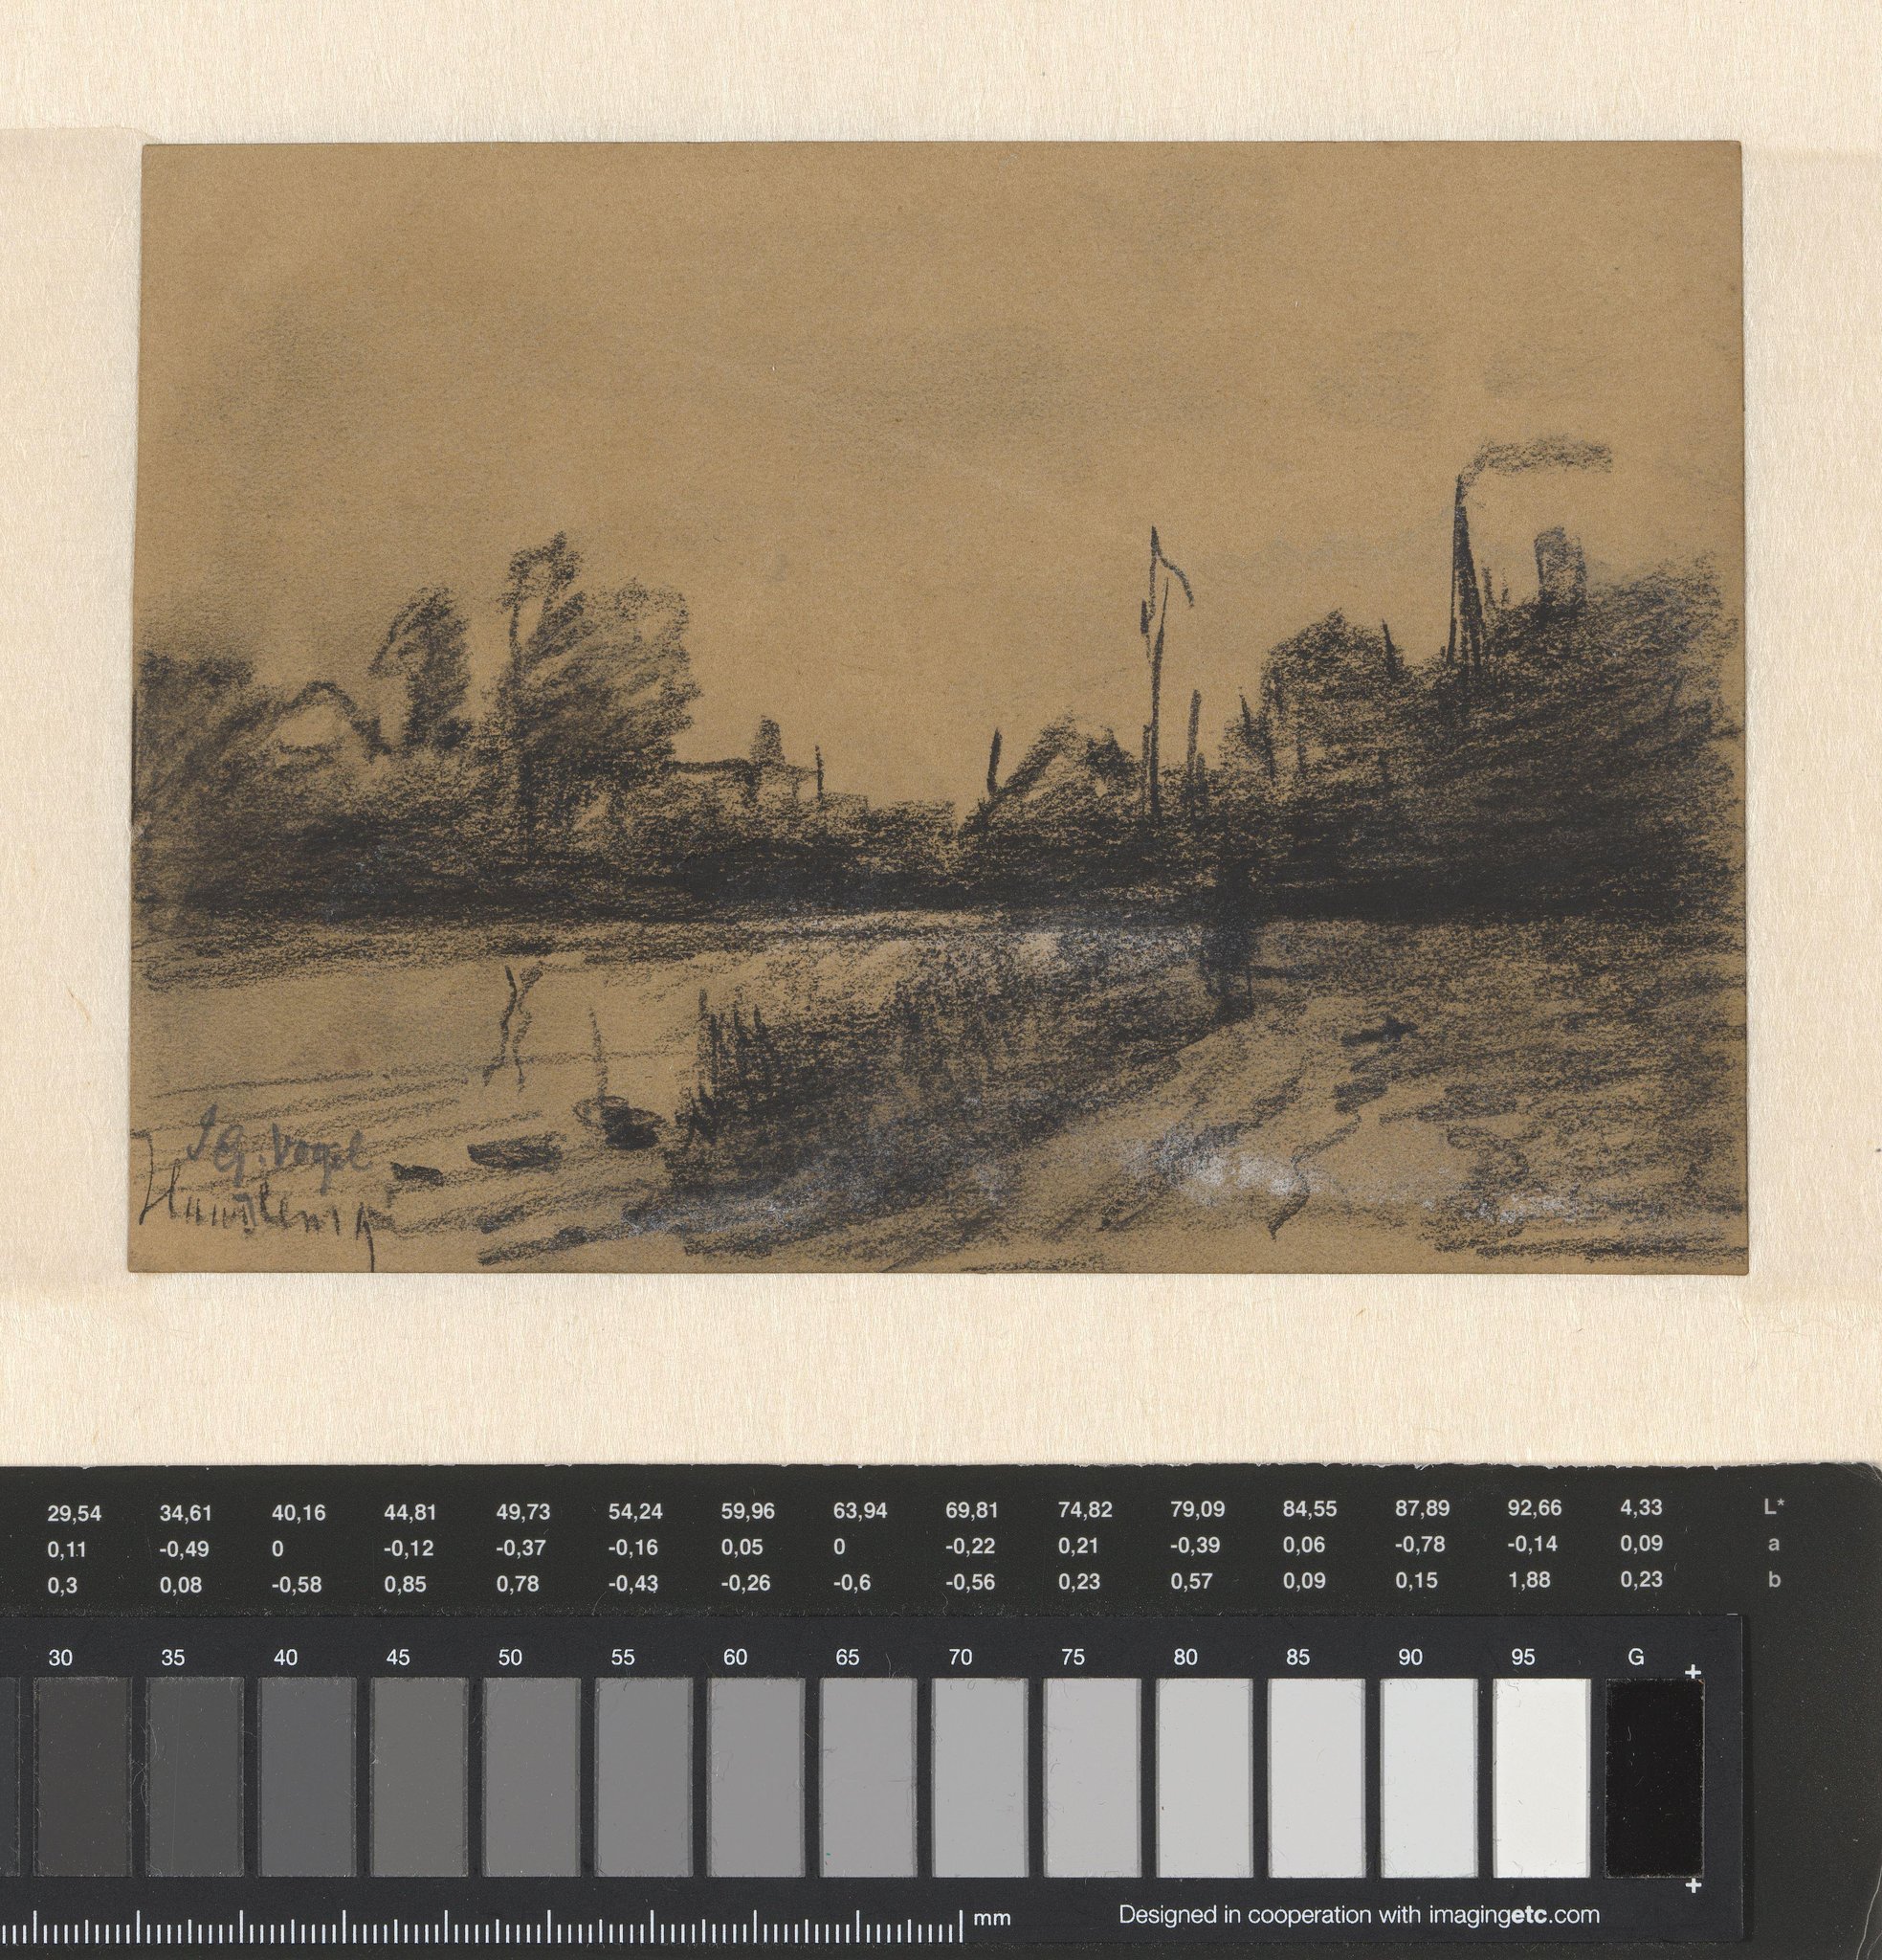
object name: drawing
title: Landschap met bebouwing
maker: johannes gijsbert vogel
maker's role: draughtsman, painter, print maker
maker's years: 1828-1915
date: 1838-1915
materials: chalk, paper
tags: city-view, and landscape with man-made constructions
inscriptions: annotation: ‘Hui[...]ig’, collector's mark: Lugt 1181b